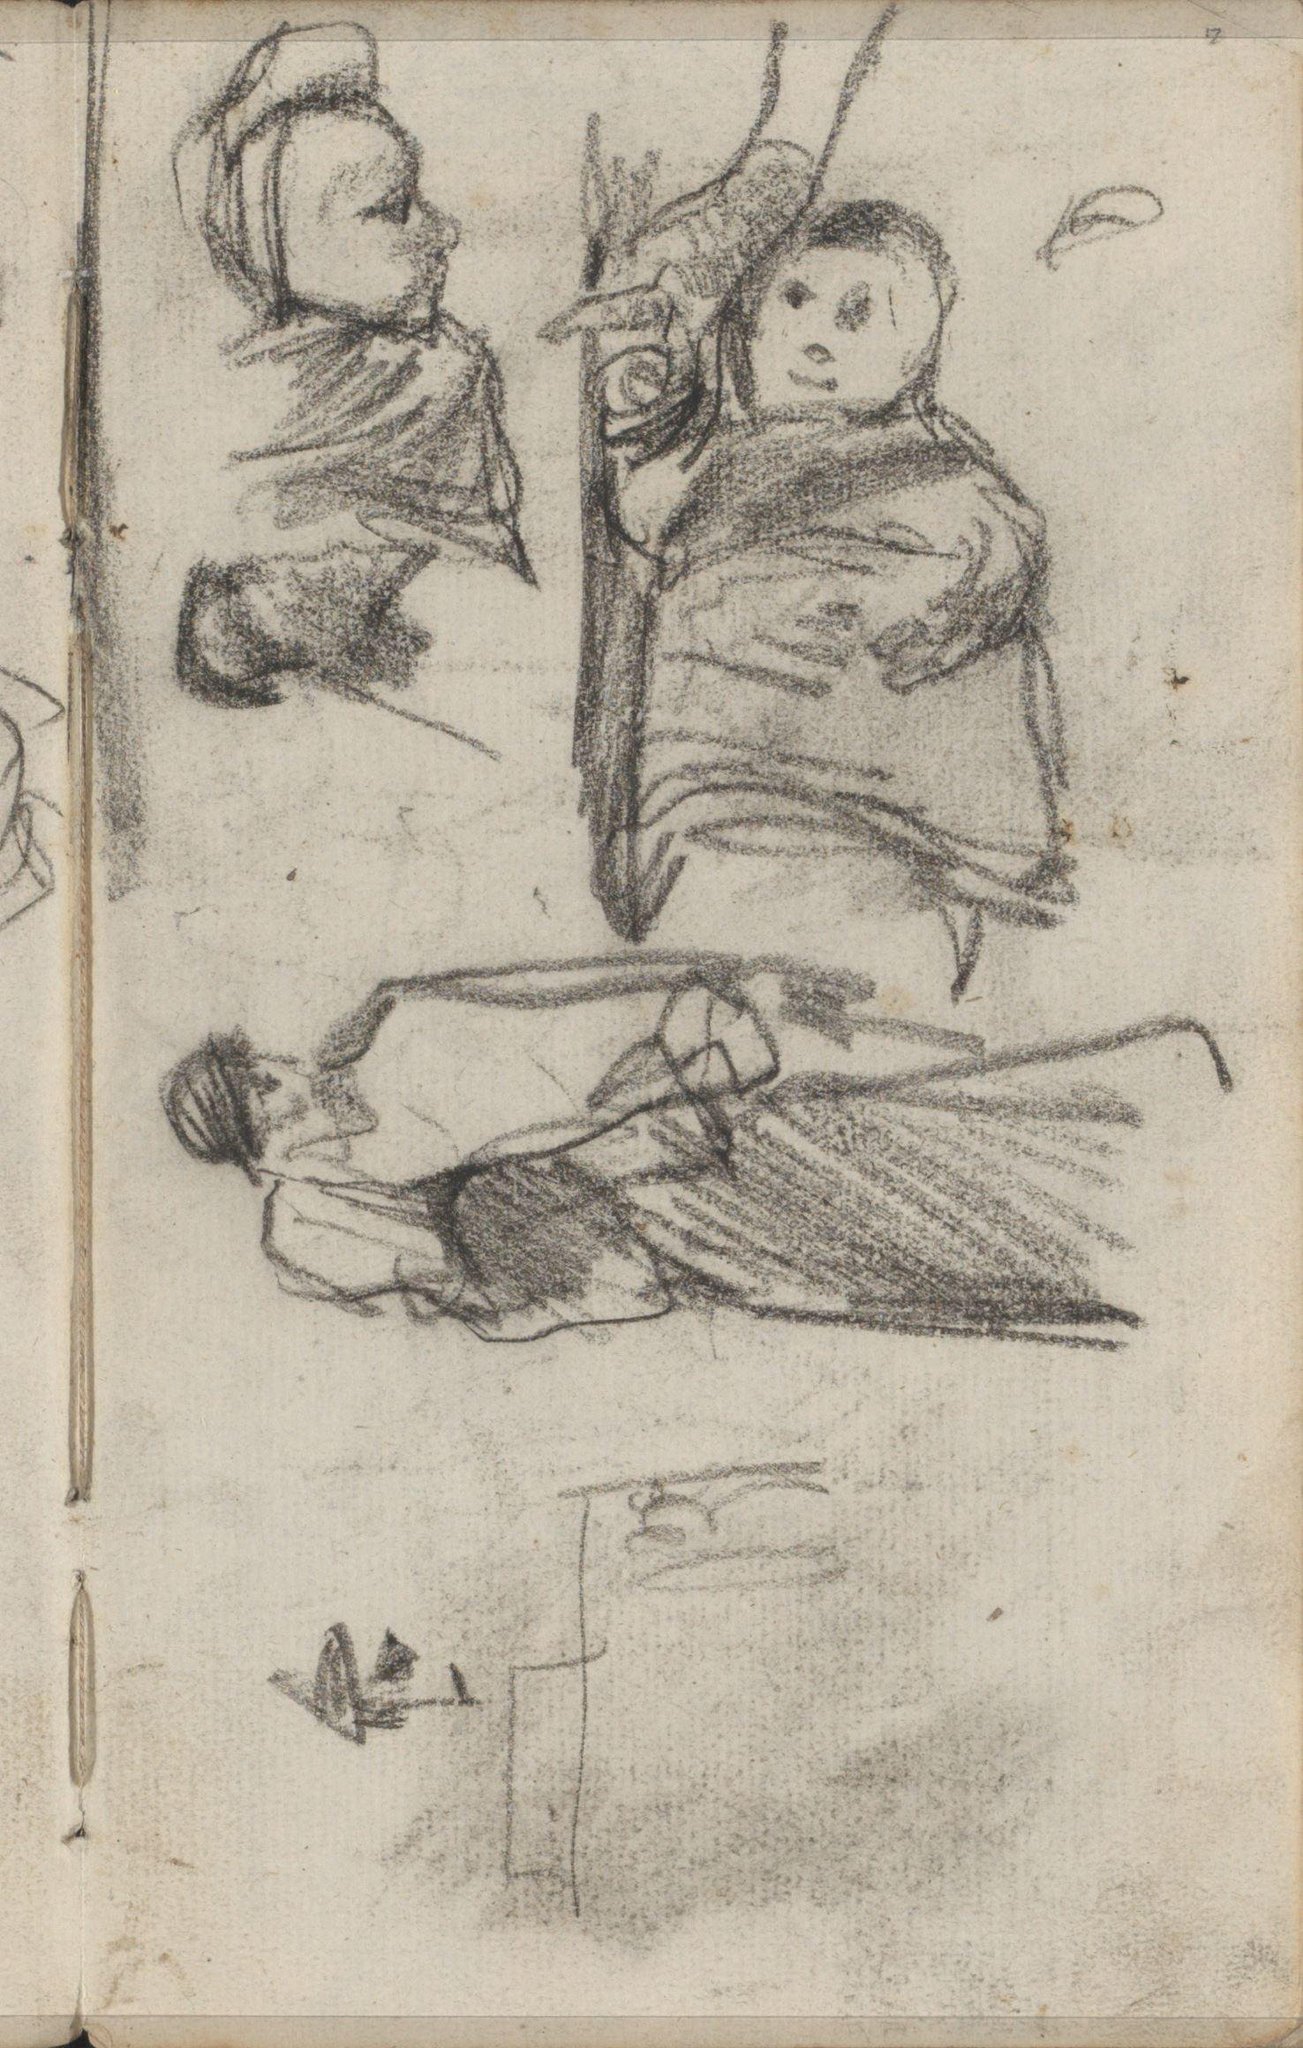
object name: sketchbook leaf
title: Figuurstudies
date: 1881-1883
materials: chalk, paper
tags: adult woman, adult man, child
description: Studies van een man, vrouw en kinderen. Pagina 12 uit een schetsboek met 27 bladen.